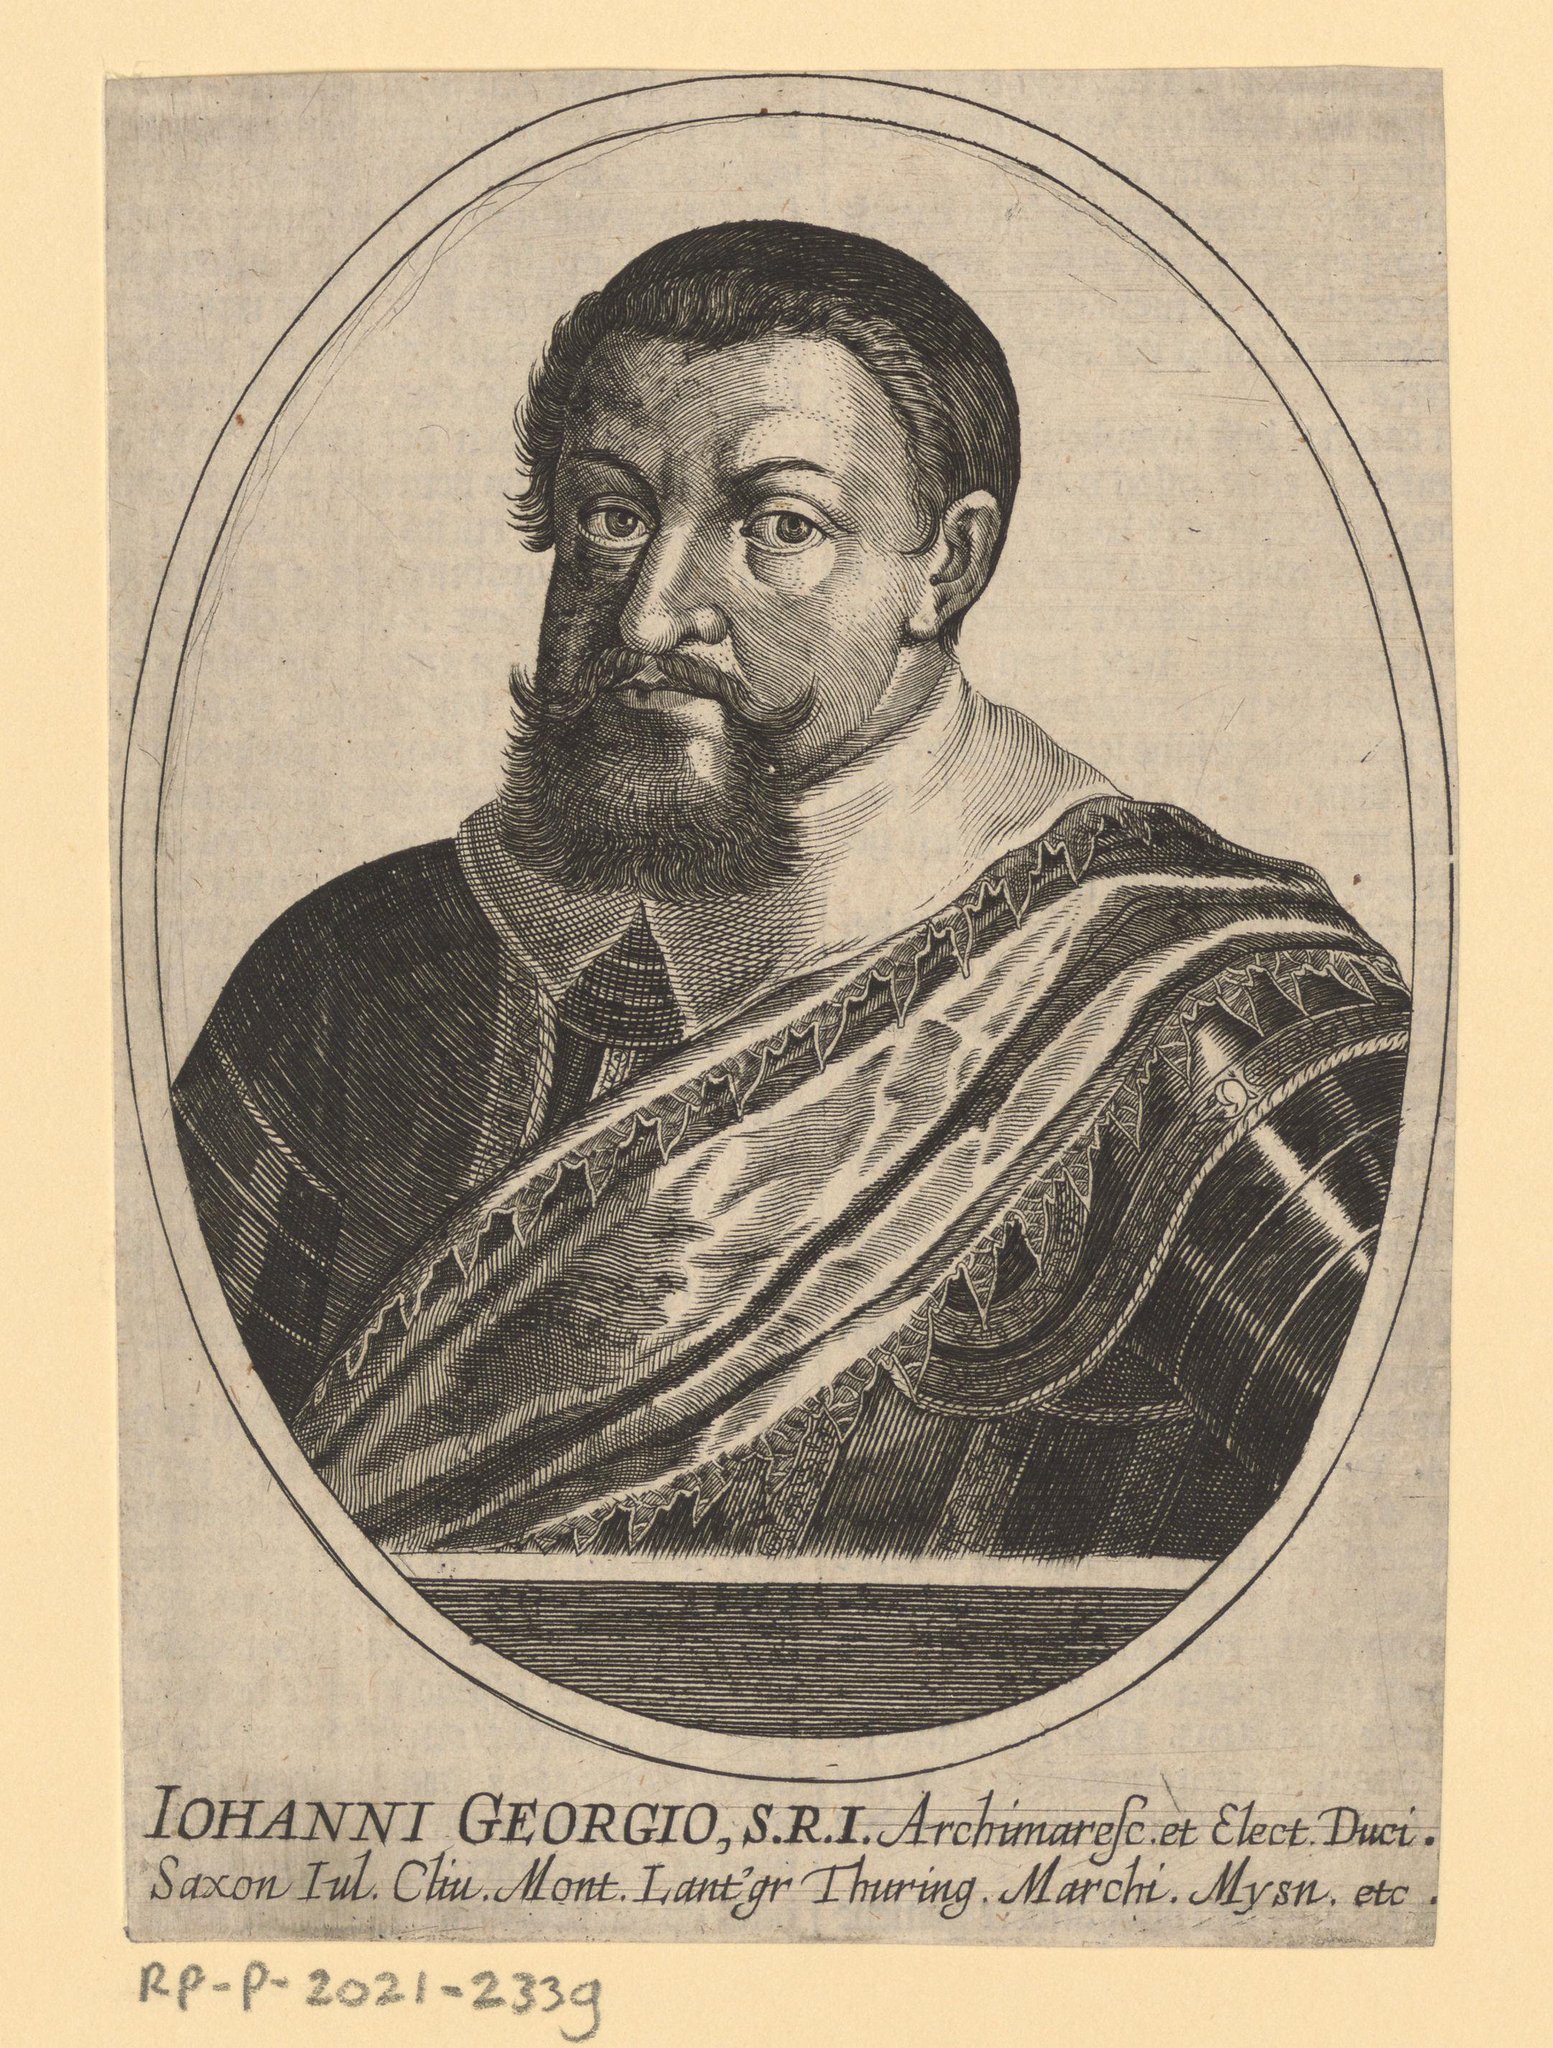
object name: print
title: Portret van Johann George I van Saksen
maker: Anonymous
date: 1642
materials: paper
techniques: engraving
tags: johann george van saksen (i), historical persons, ruler, sovereign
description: Prent met andere tekst op verso gebruikt in: Danckerts, Cornelis I. Historis oft waerachtich verhael van den gantschen toestant van oorlooge (...). Amsterdam: Cornelis Danckerts I, 1642, dl. 1, p. 9.